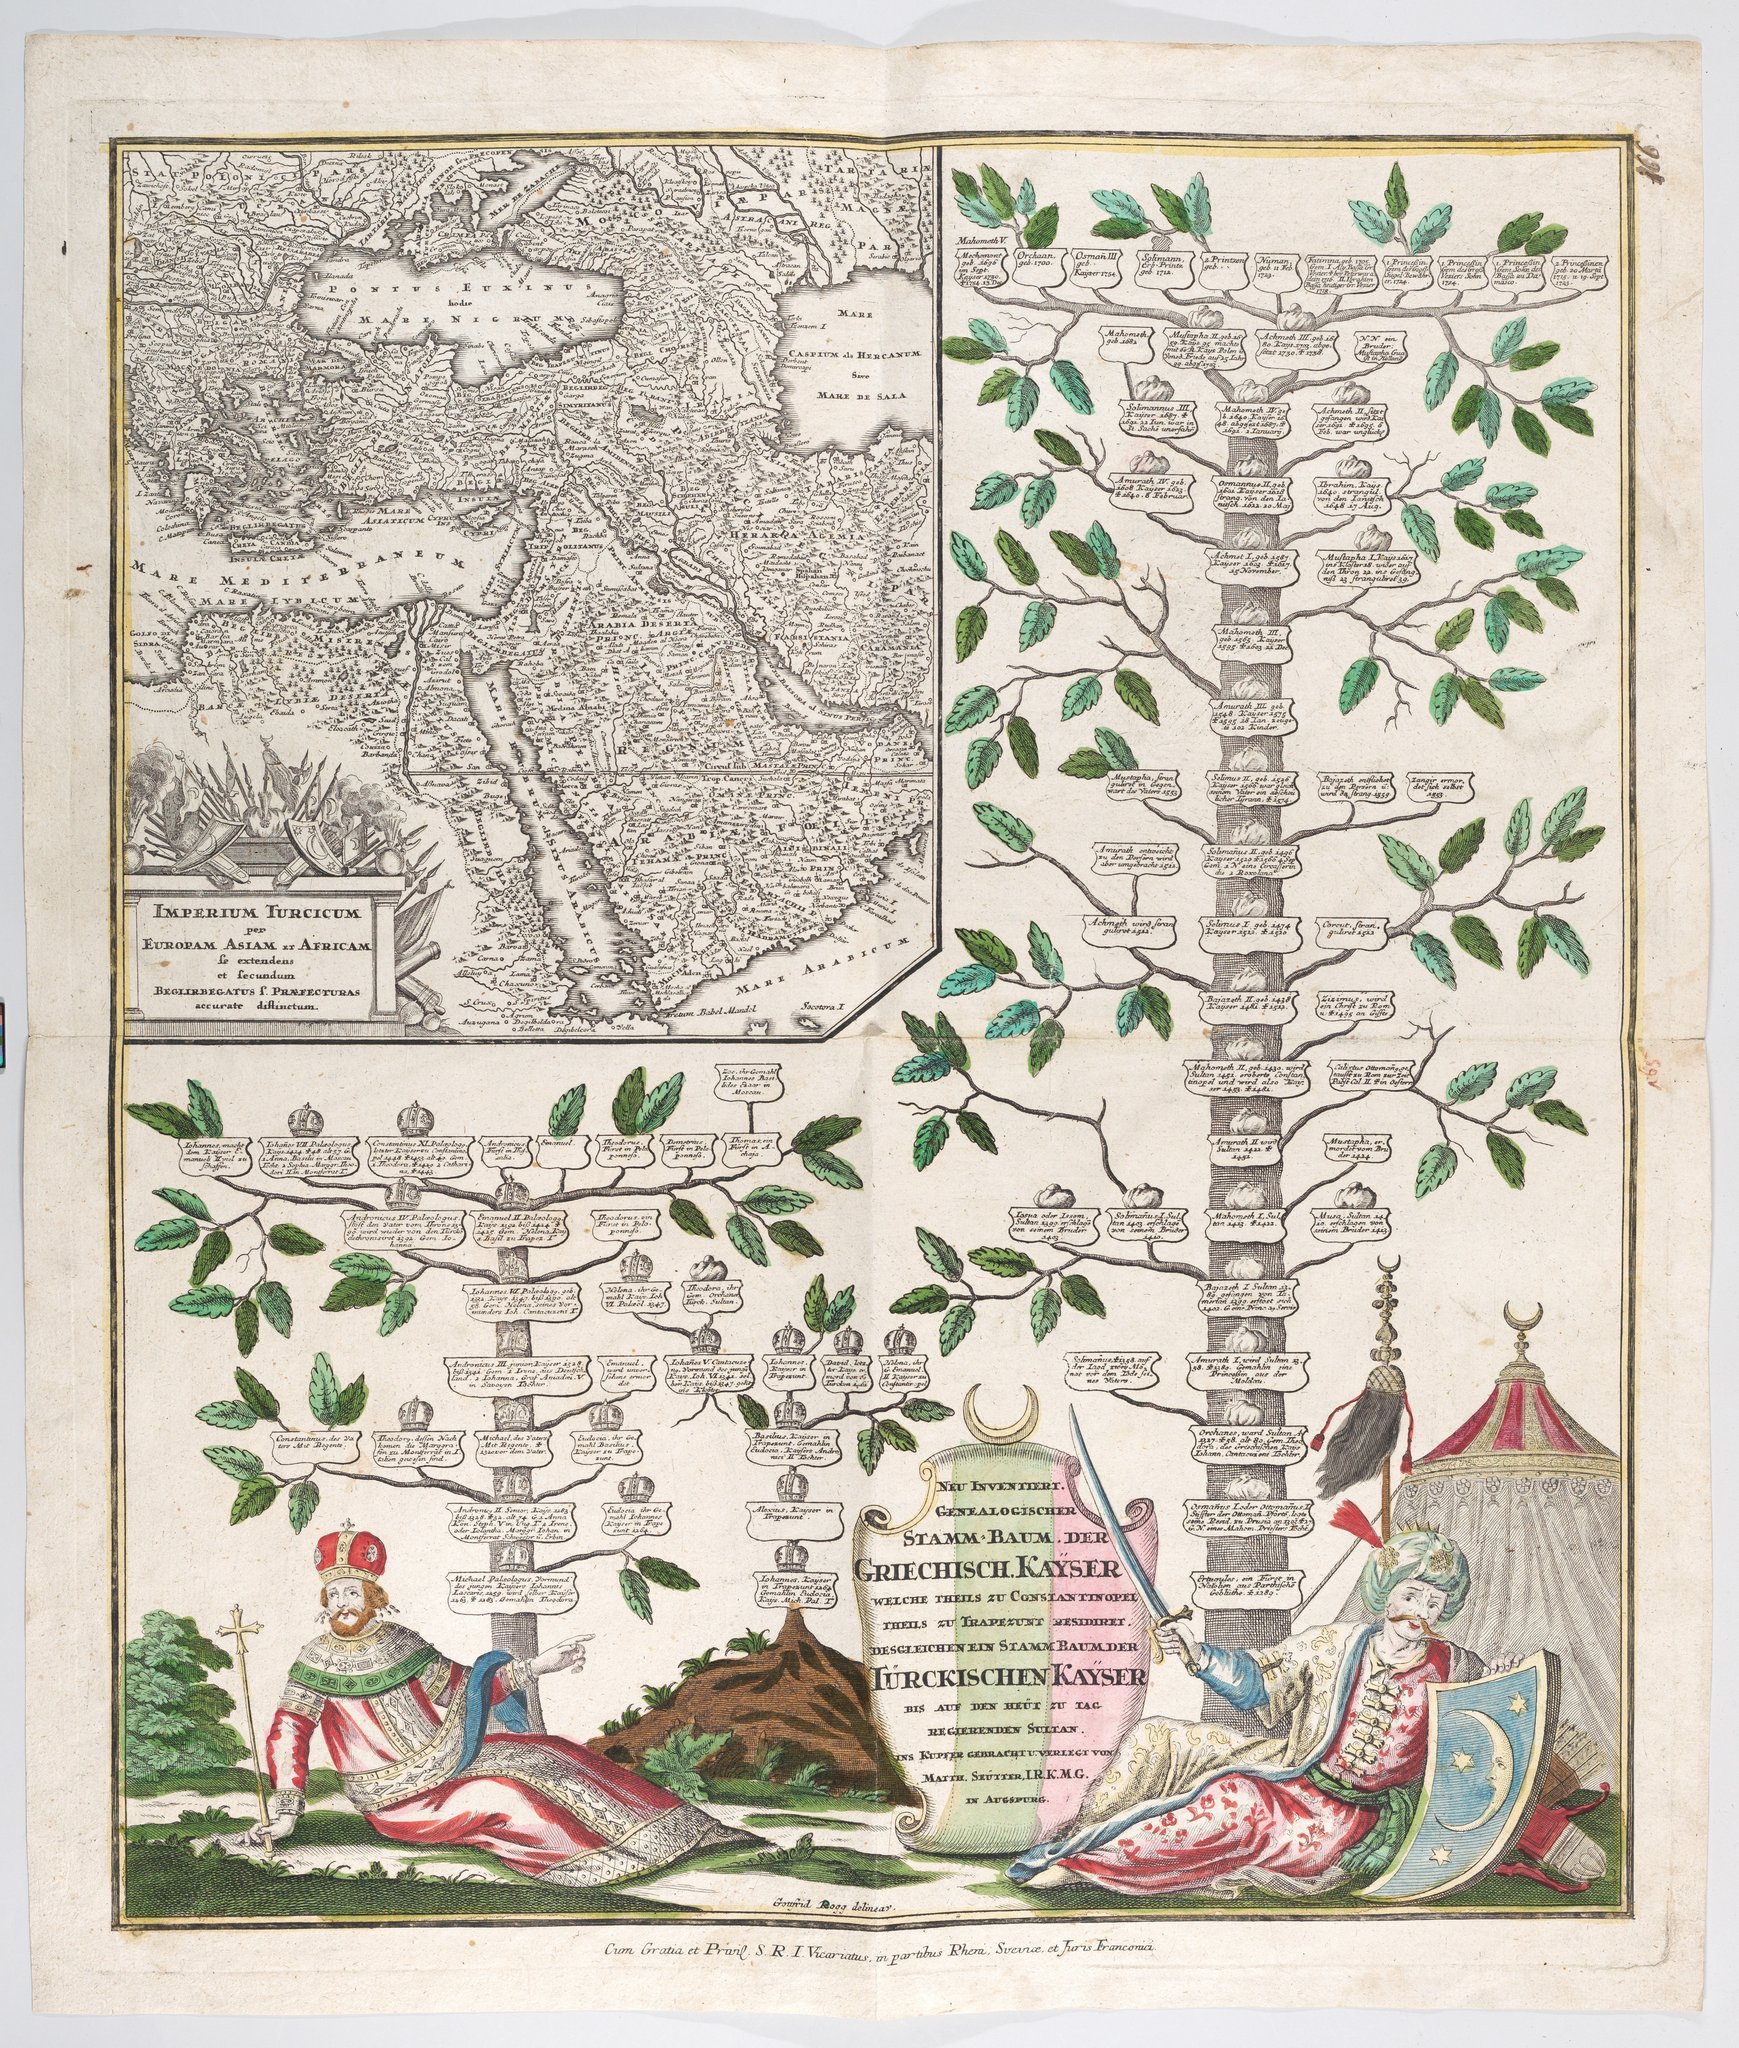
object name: engraving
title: Neu inventiert genealogischer Stamm-Baum der Griechisch Kayser... desgleichen ein Stamm-Baum der Türckischen Kayser (A newly invented genealogical tree of the last Byzantine emperor...as well as one of the Turkish sultan)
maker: gottfried rogg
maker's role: artist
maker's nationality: german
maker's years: 1669-1743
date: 1730-1757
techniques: engraving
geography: augsburg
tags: emperors,trees,maps